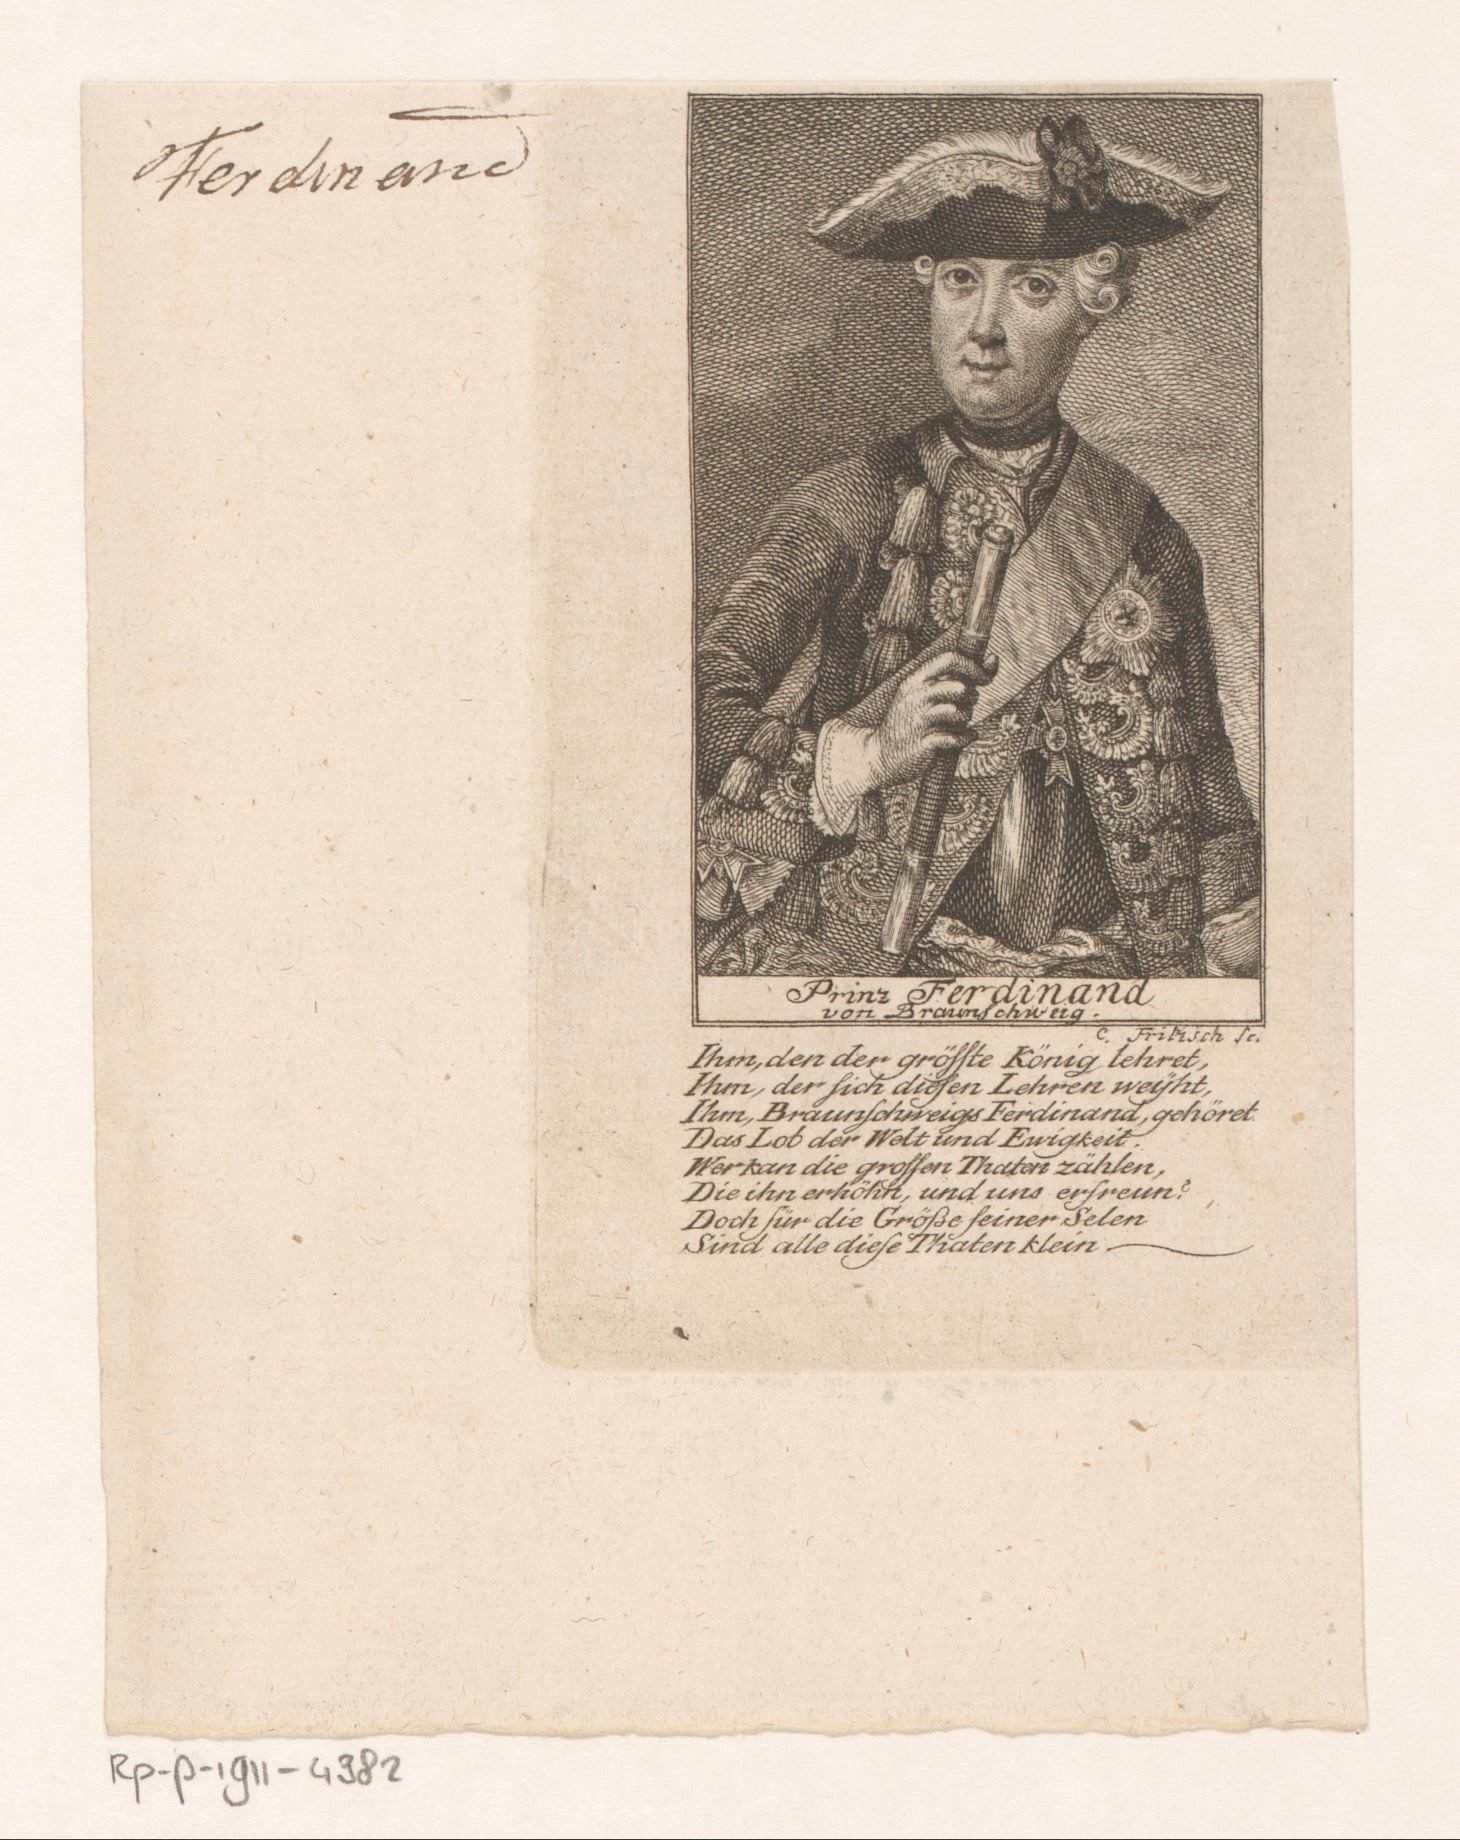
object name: print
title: Portret van Ferdinand van Brunswijk-Lüneburg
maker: christian fritzsch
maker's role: print maker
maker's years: 1695-1769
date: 1731-1769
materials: paper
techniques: engraving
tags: knighthood order (with name) - insignia of a knighthood order, e.g.: badge, chain (with name of order), historical persons, baton of general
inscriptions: collector's mark: Lugt 2228